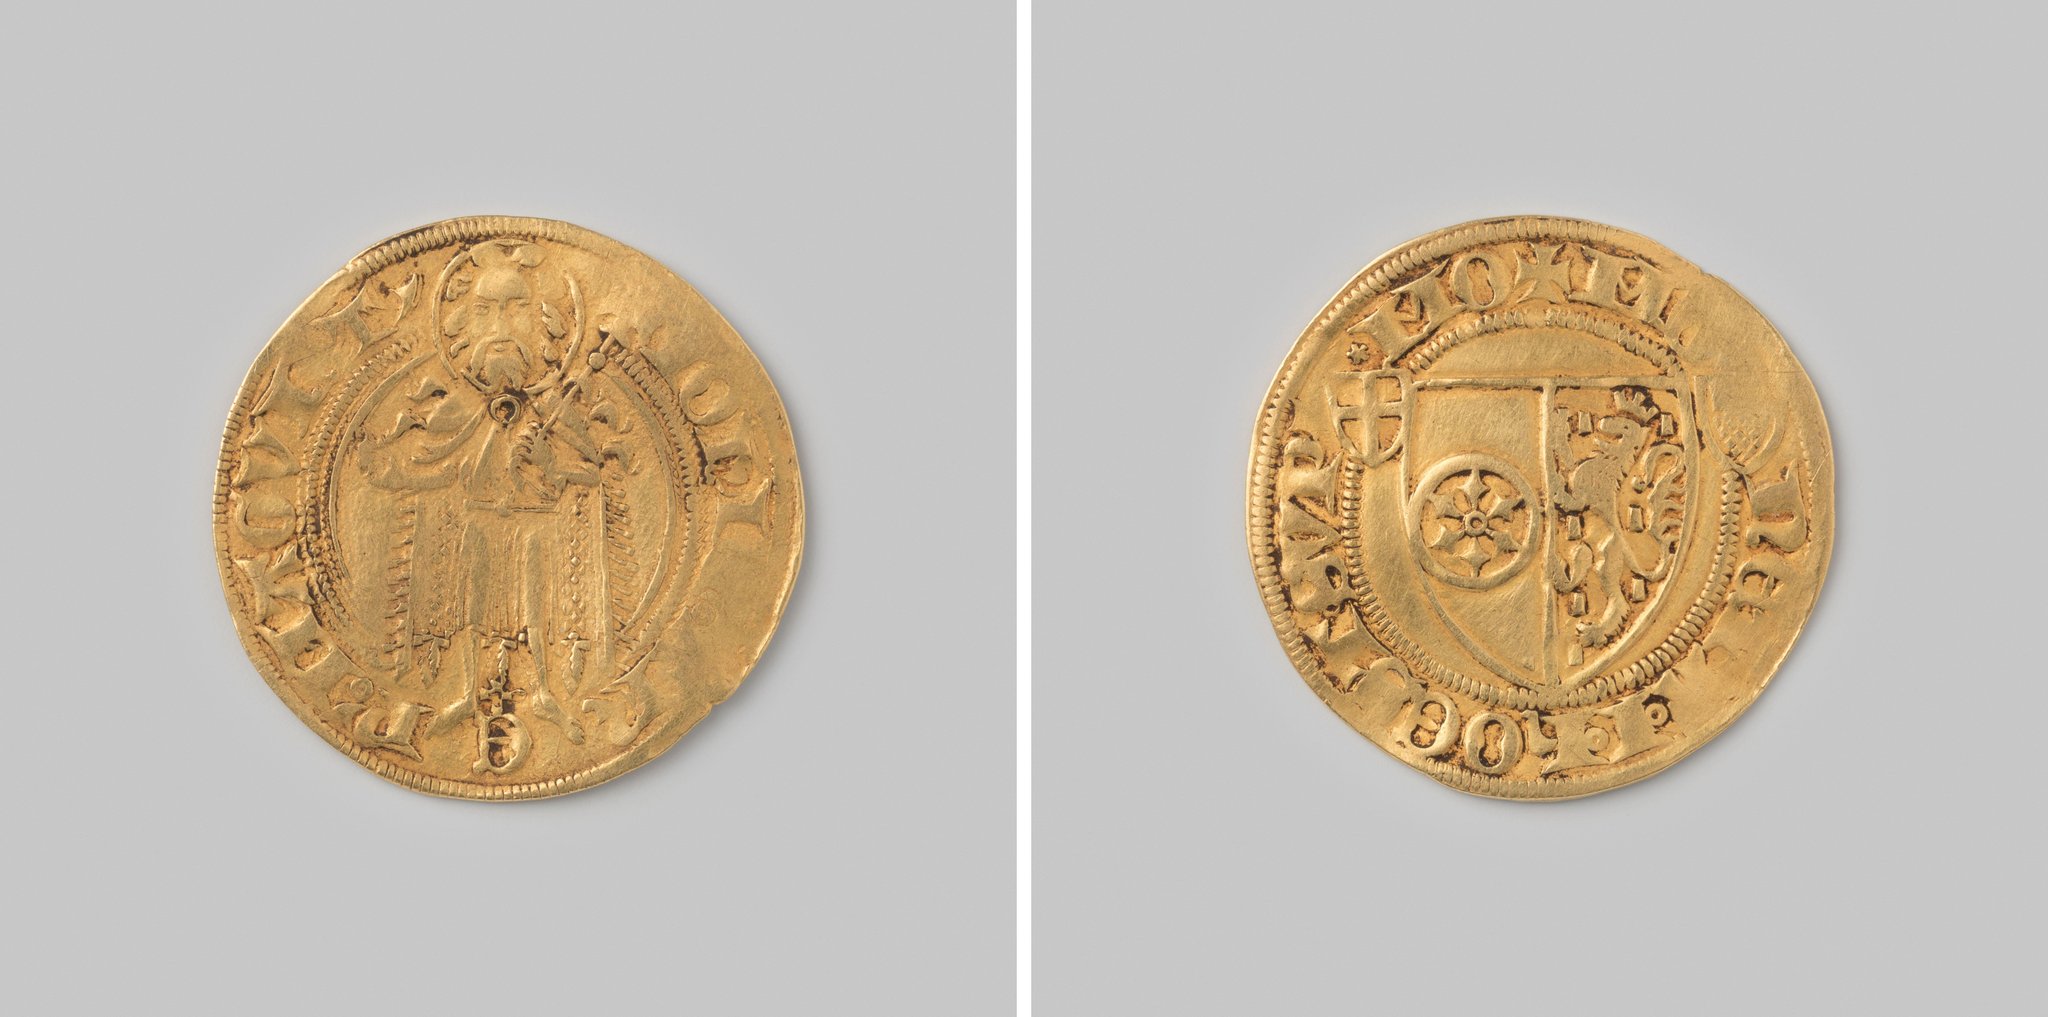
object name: coin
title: Aartsbisdom en keurvorstendom Mainz, goudgulden, Jan II van Nassau,1397-1419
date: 1397-1419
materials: gold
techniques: striking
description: Gouden munt. Voorzijde: staande Johannes de Doper, van voren. Keerzijde: tussen twee kleine wapenschilden samengesteld wapenschild van Mainz-Nassau. Geslagen te Höchst. Afkomstig uit muntvondst Merula-weeshuis, Den Briel 1929.